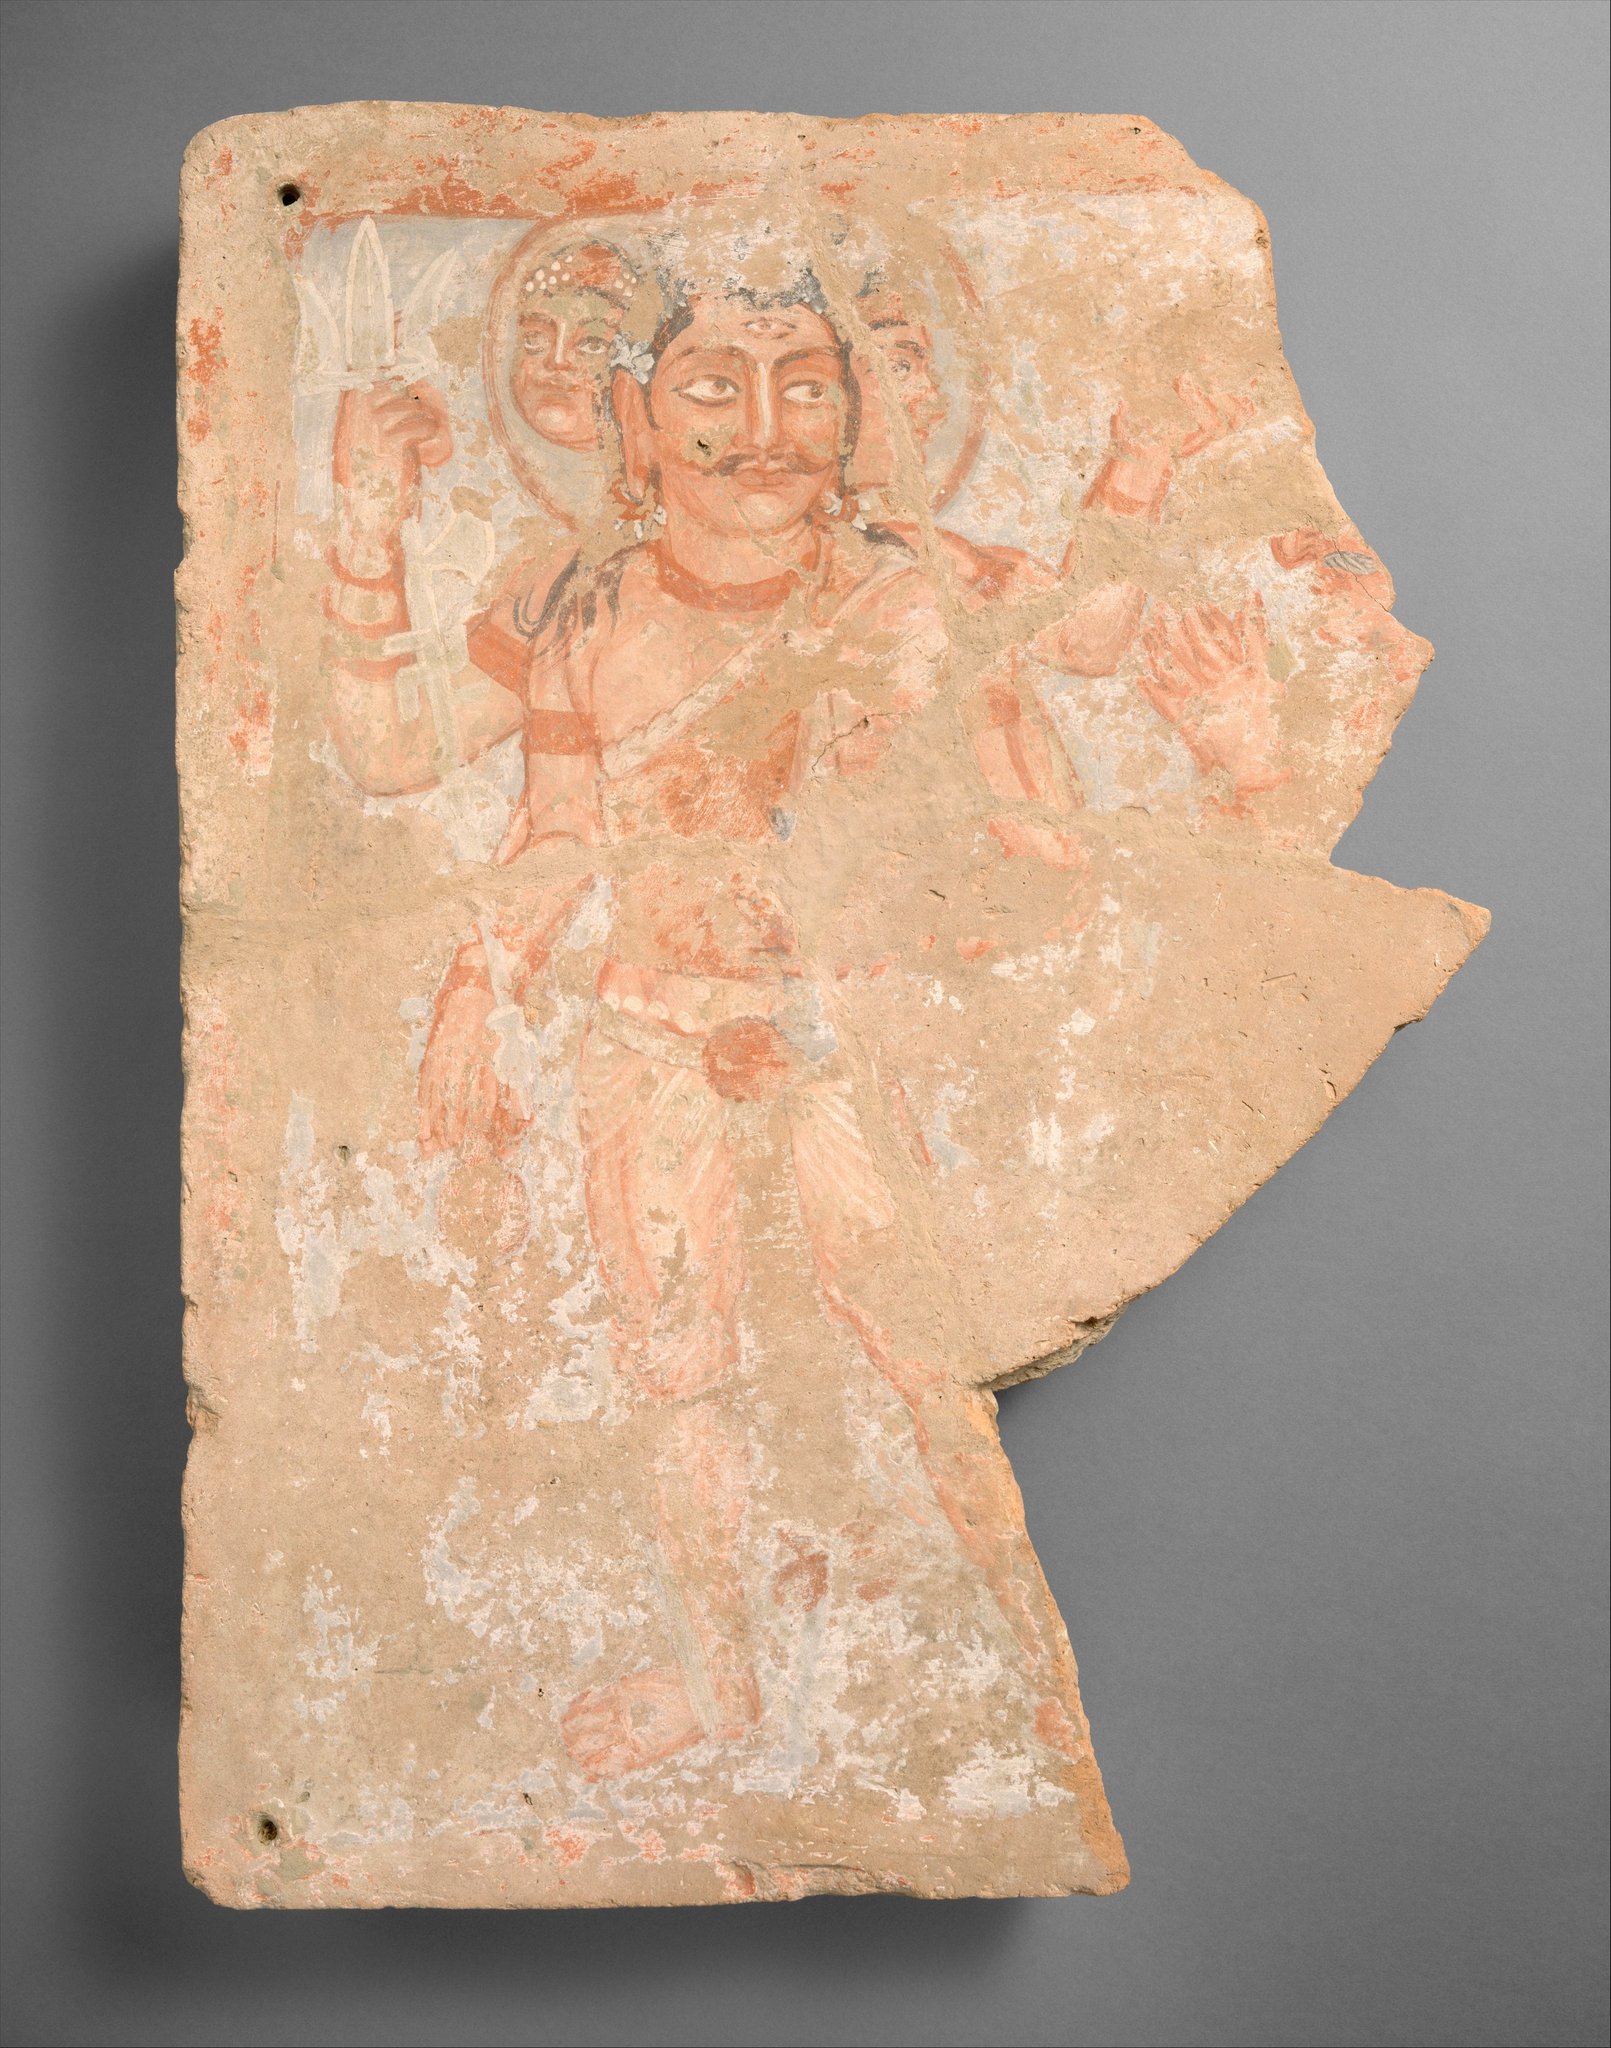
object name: painted panel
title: Panel fragment with the god Shiva/Oesho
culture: kushan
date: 201-300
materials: gouache, terracotta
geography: bactria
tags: deities